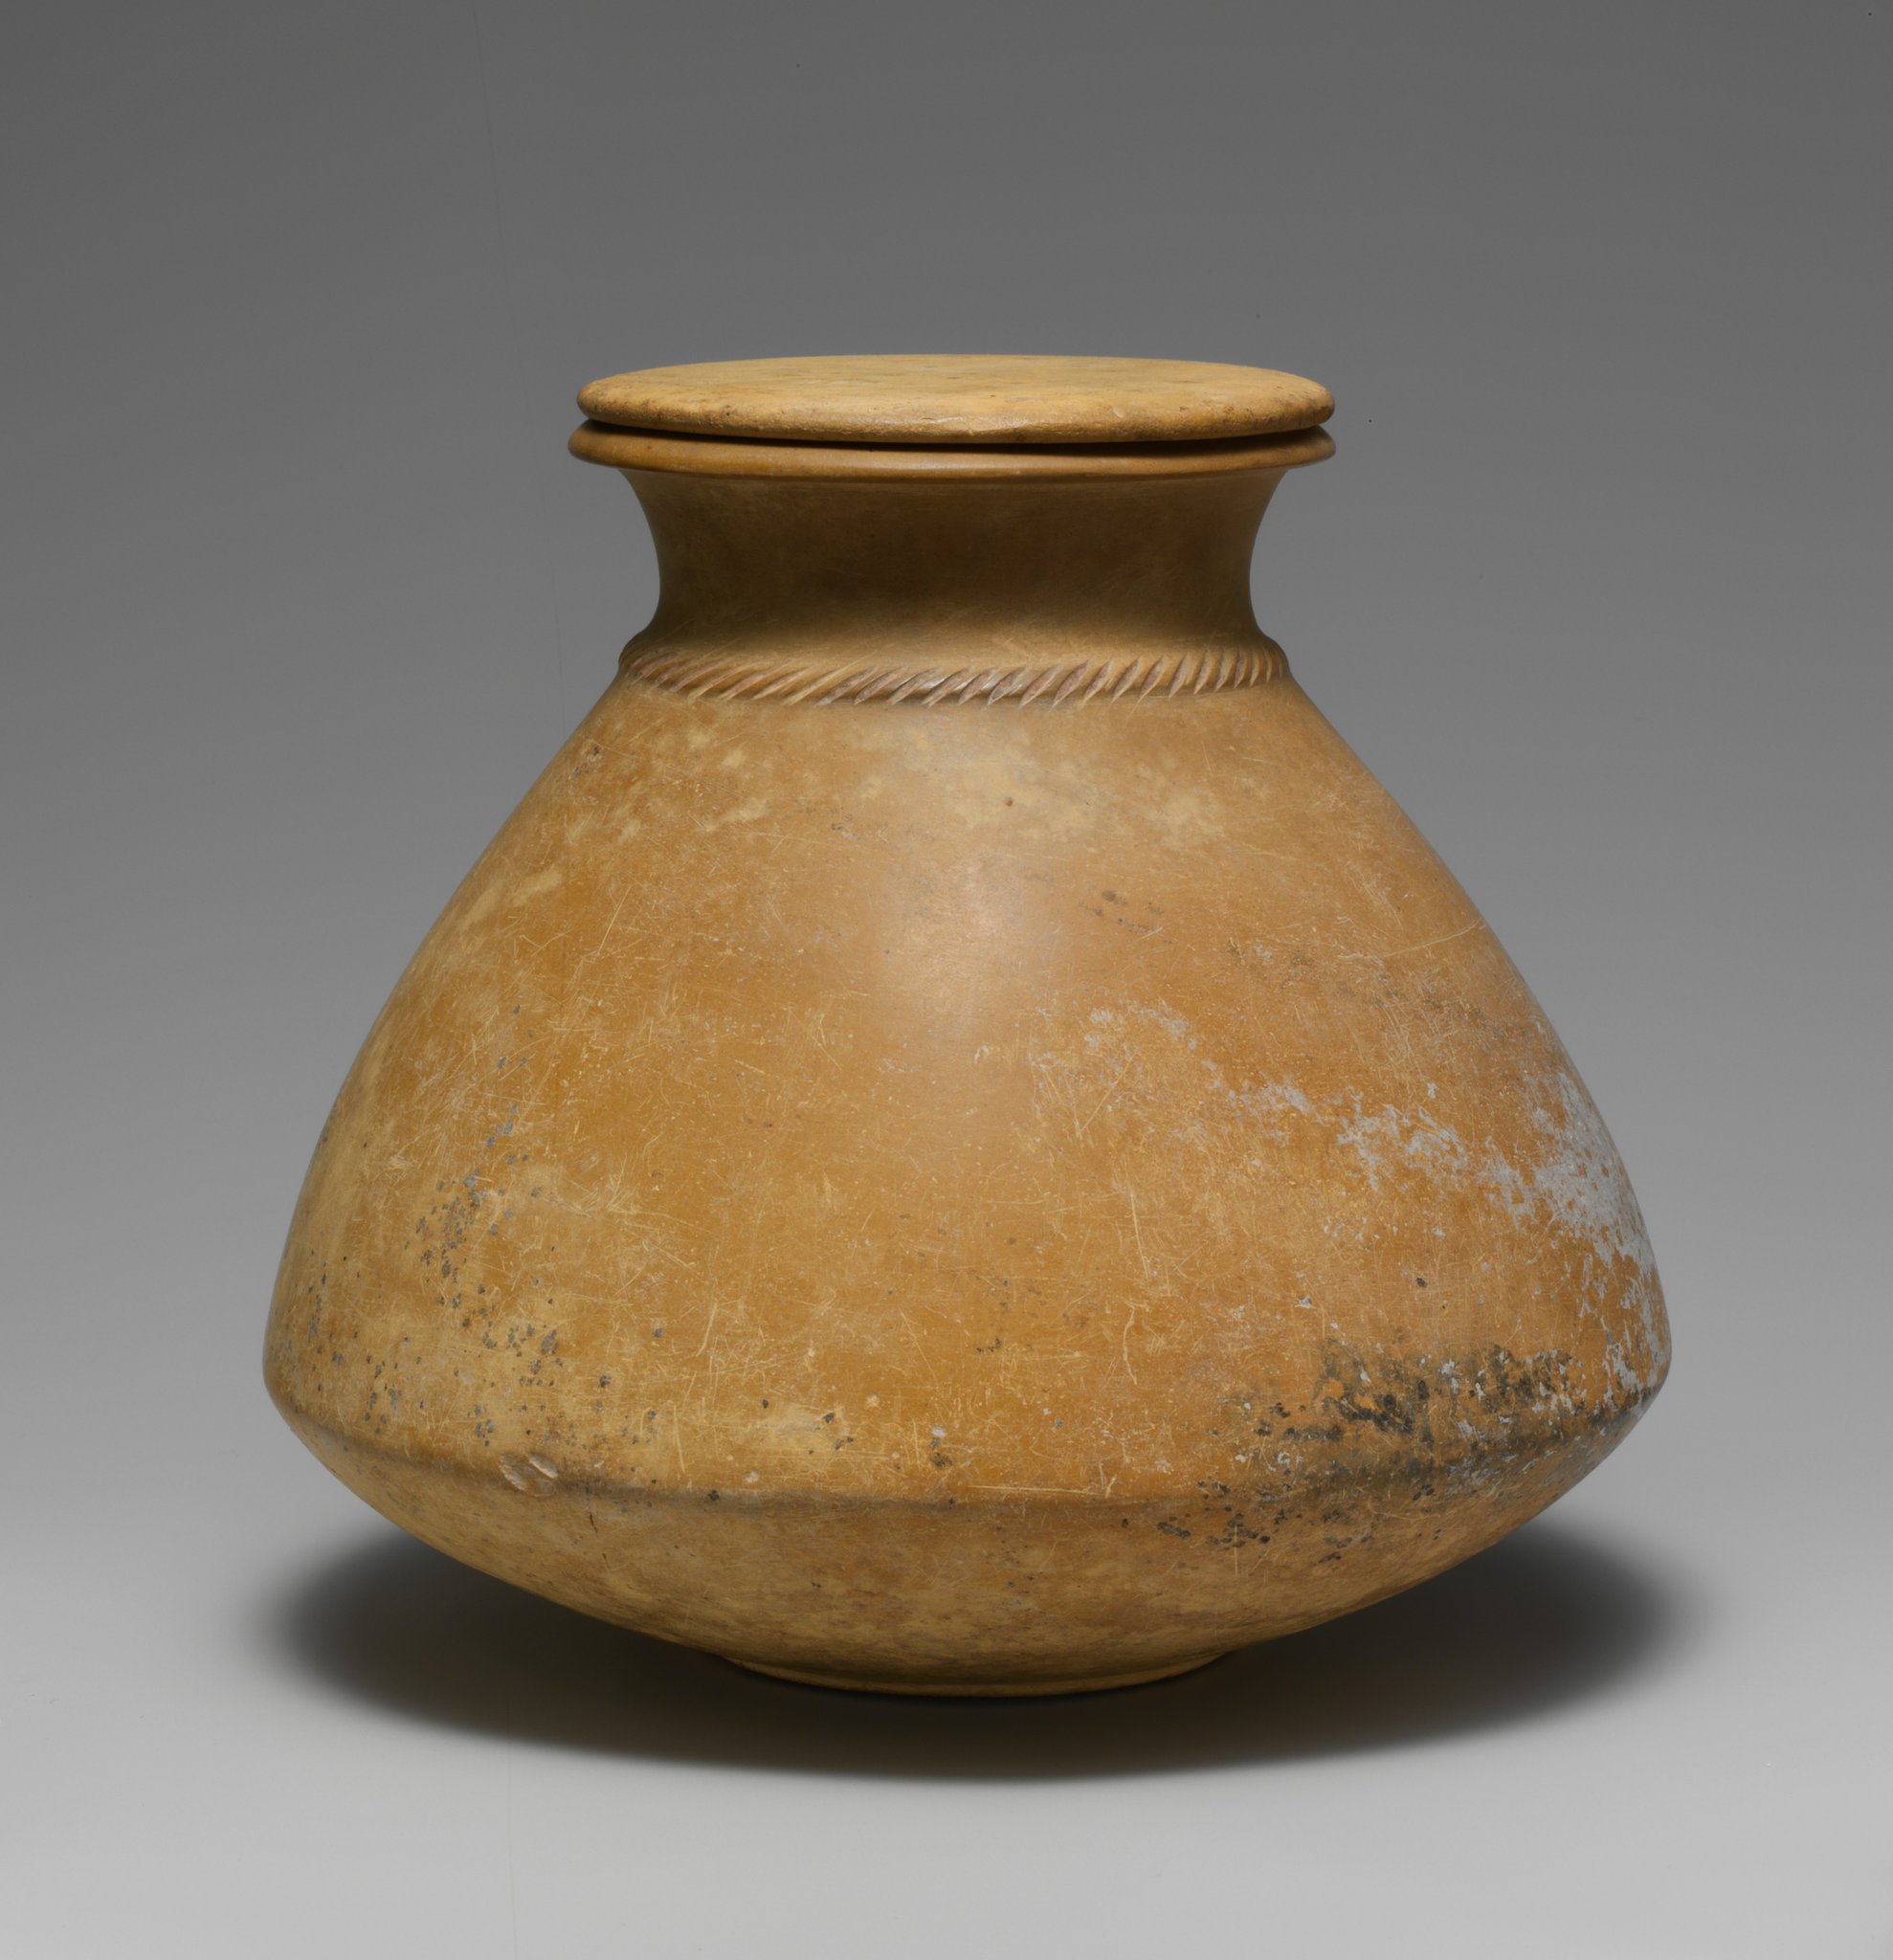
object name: jar, carinated, rope pattern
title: Carinated Stone Jar with Rope Pattern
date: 1550-1458 BCE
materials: limestone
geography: egypt